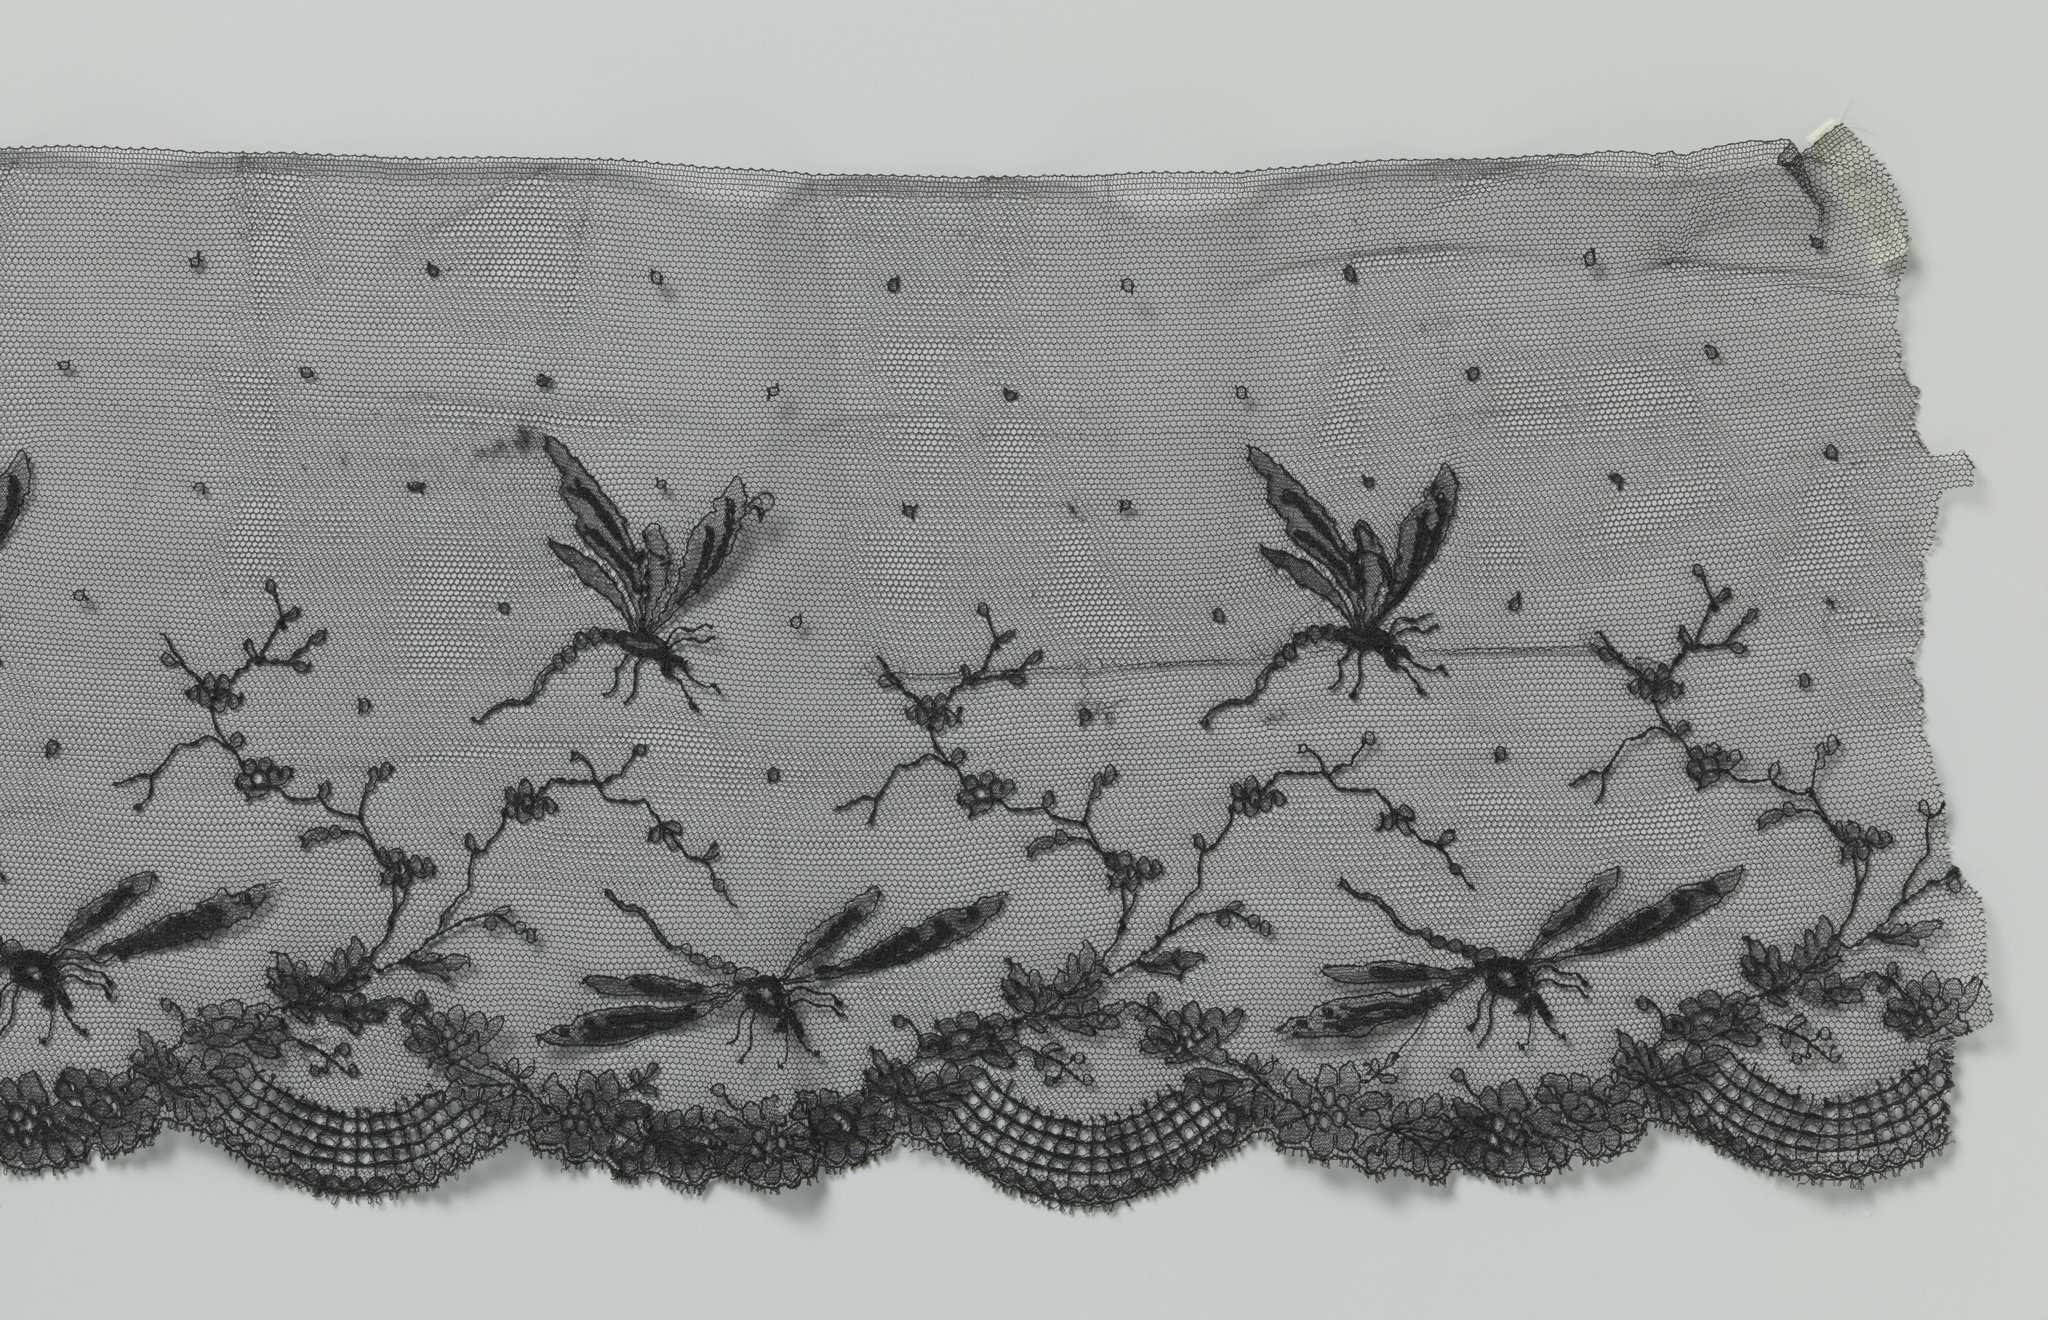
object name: strip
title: Strook zwarte machinale kant met libellen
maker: Anonymous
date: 1890-1899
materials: cotton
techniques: lace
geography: calais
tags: insects: dragon-fly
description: Strook zwarte machinale kant: machinale Chantilly-kant. Het zich herhalende patroon bestaat uit twee, bijna recht boven elkaar geplaatste, vliegende libellen. De vleugels van de bovenste libelle zijn meer omhoog gericht en die van de onderste libelle zijwaarts. Een ijle, gespleten rozentak met enkele bloempjes en blaadjes ontspringt onderaan de strook aan een golvende lijn, die bestaat uit een aaneenschakeling van rozentakjes. Onder elke golftop hangt een gebogen korte sierband met een vierkant raster. De motieven zijn voorzien van contourdraden en zijn met elkaar verbonden door een machinale tulegrond, die is bezaaid met moesjes. Als siergrond is onder andere een machinale rozengrond toegepast in de gebogen sierband en in de bloemharten. De gebogen sierband vormt onder de toppen van de doorgaande golvende rozentakjes de schulpenrand, die is afgewerkt met picots. De bovenzijde van de strook is recht afgewerkt.